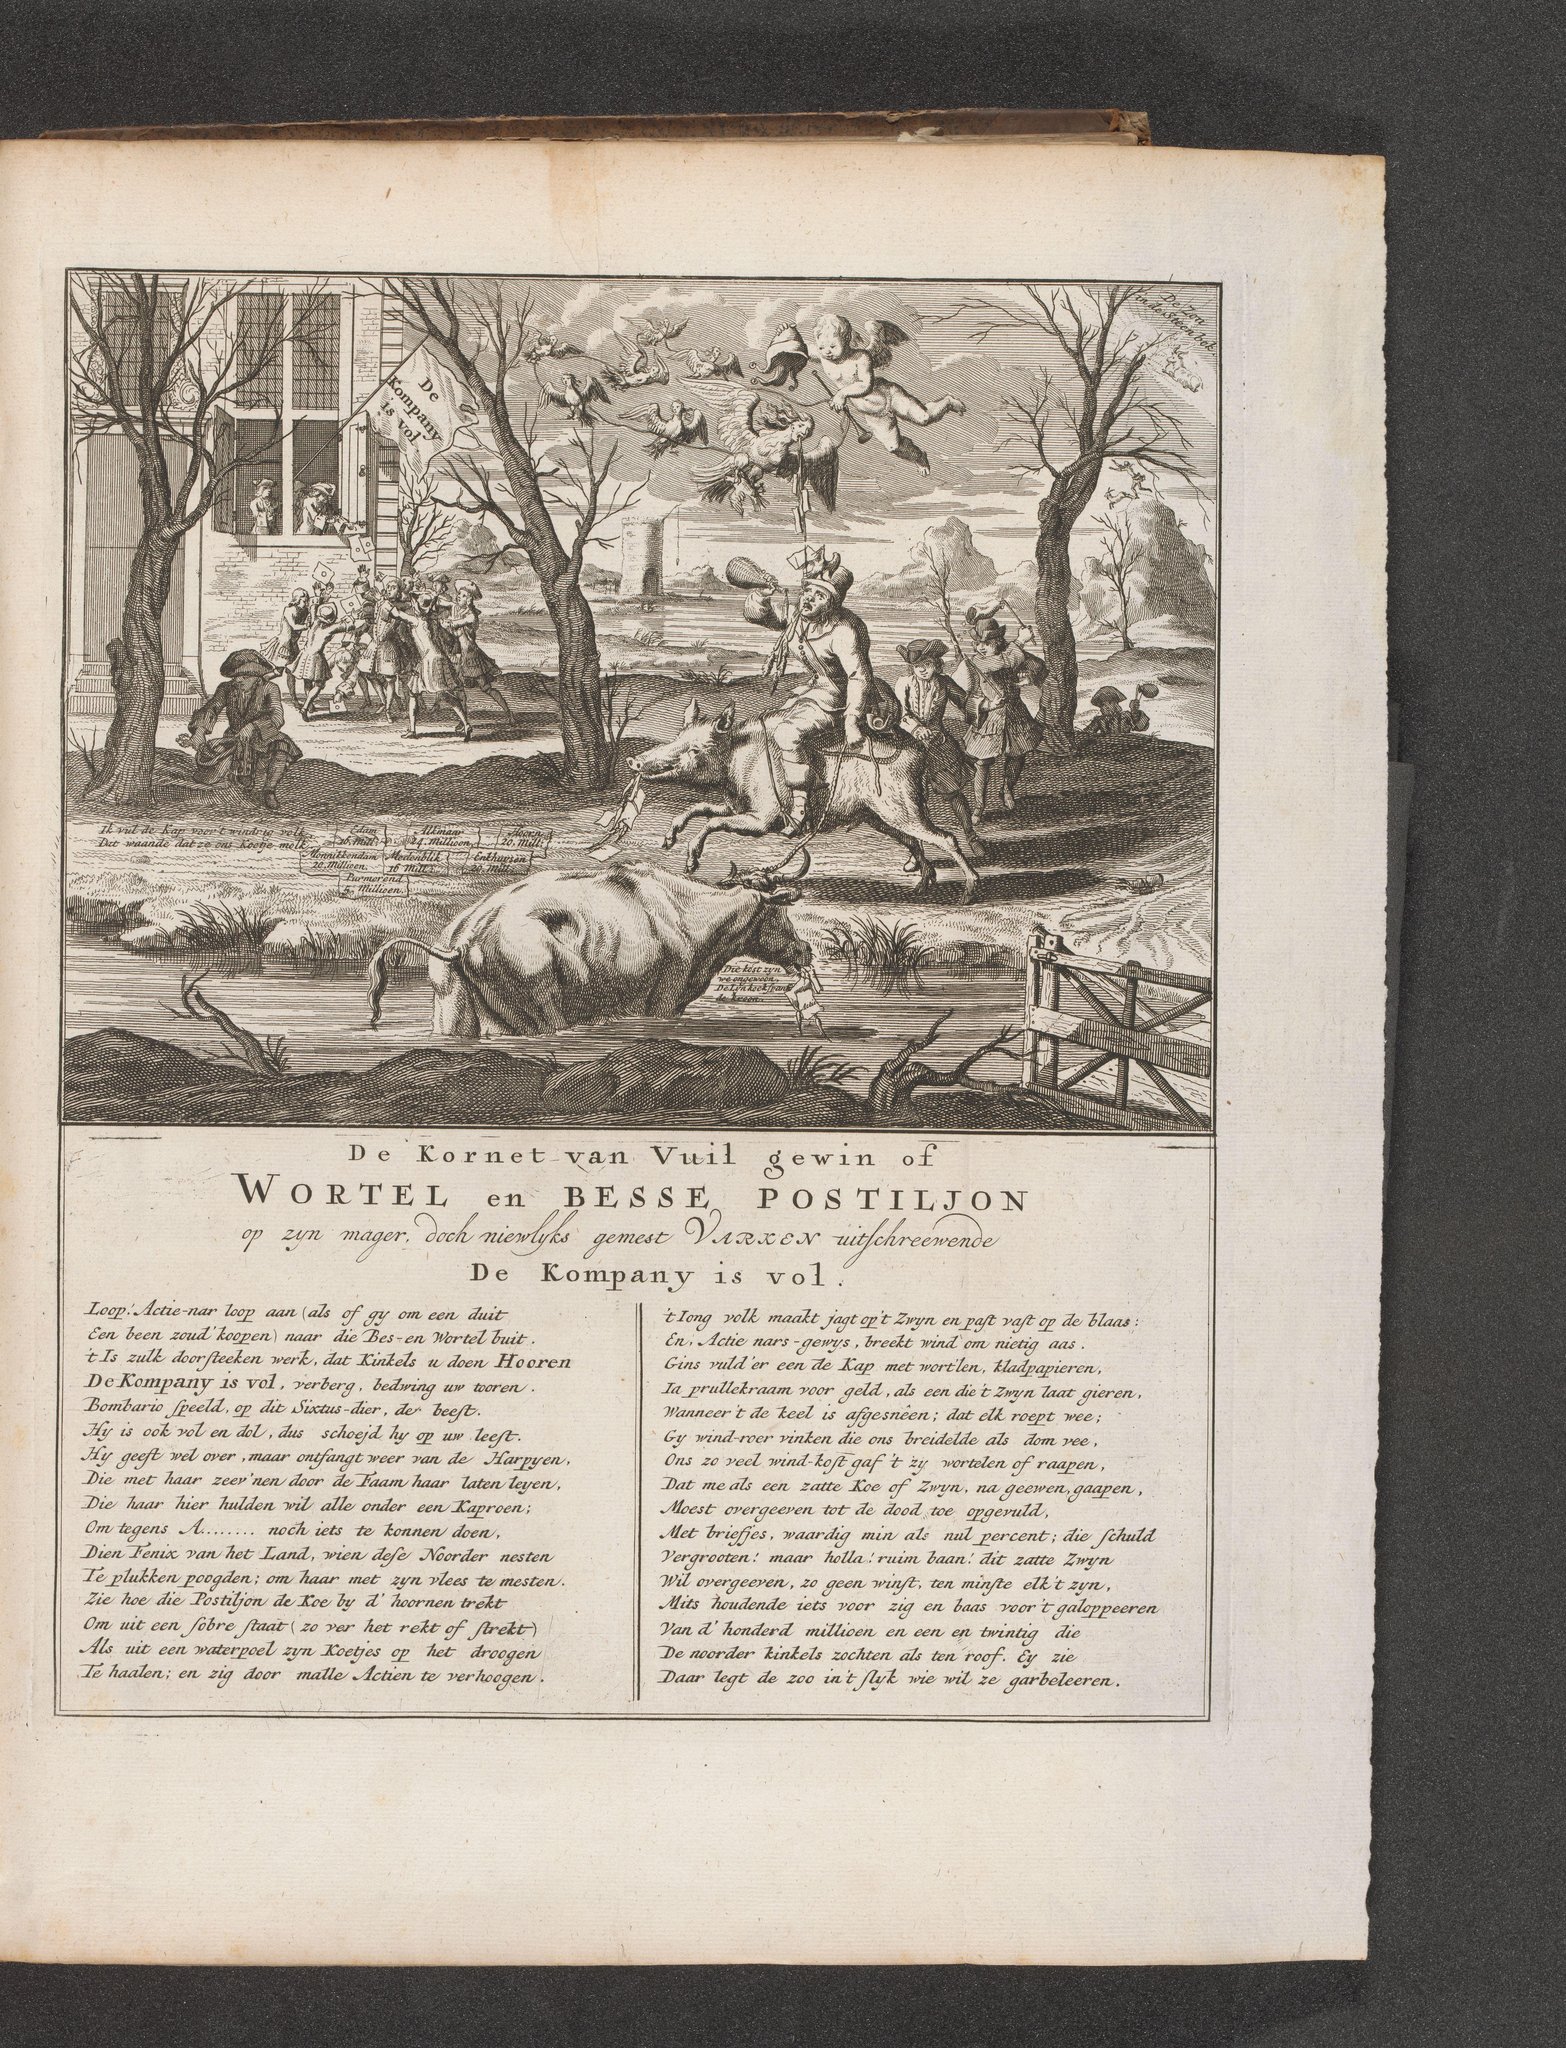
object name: cartoon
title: Postiljon op een varken brengt het nieuws dat de compagnie vol is, 1720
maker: Anonymous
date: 1720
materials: paper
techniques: engraving, etching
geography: northern netherlands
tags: messenger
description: Een postiljon op een varken verspreidt het nieuws dat de compagnie vol is. Op de voorgrond kauwt een koe in een sloot op de waardeloze aandelen. Links op de achtergrond verdringen windhandelaren zich bij de uitgifte van aandelen. In het onderschrift een vers in twee kolommen. Prent in de gebonden vierde uitgave (304 B 12) van Het Groote Tafereel der Dwaasheid met spotprenten op de Windhandel of Actiehandel van 1720.